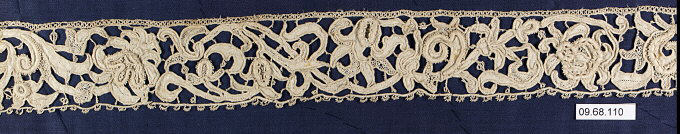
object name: border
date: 1634-1666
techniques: lace